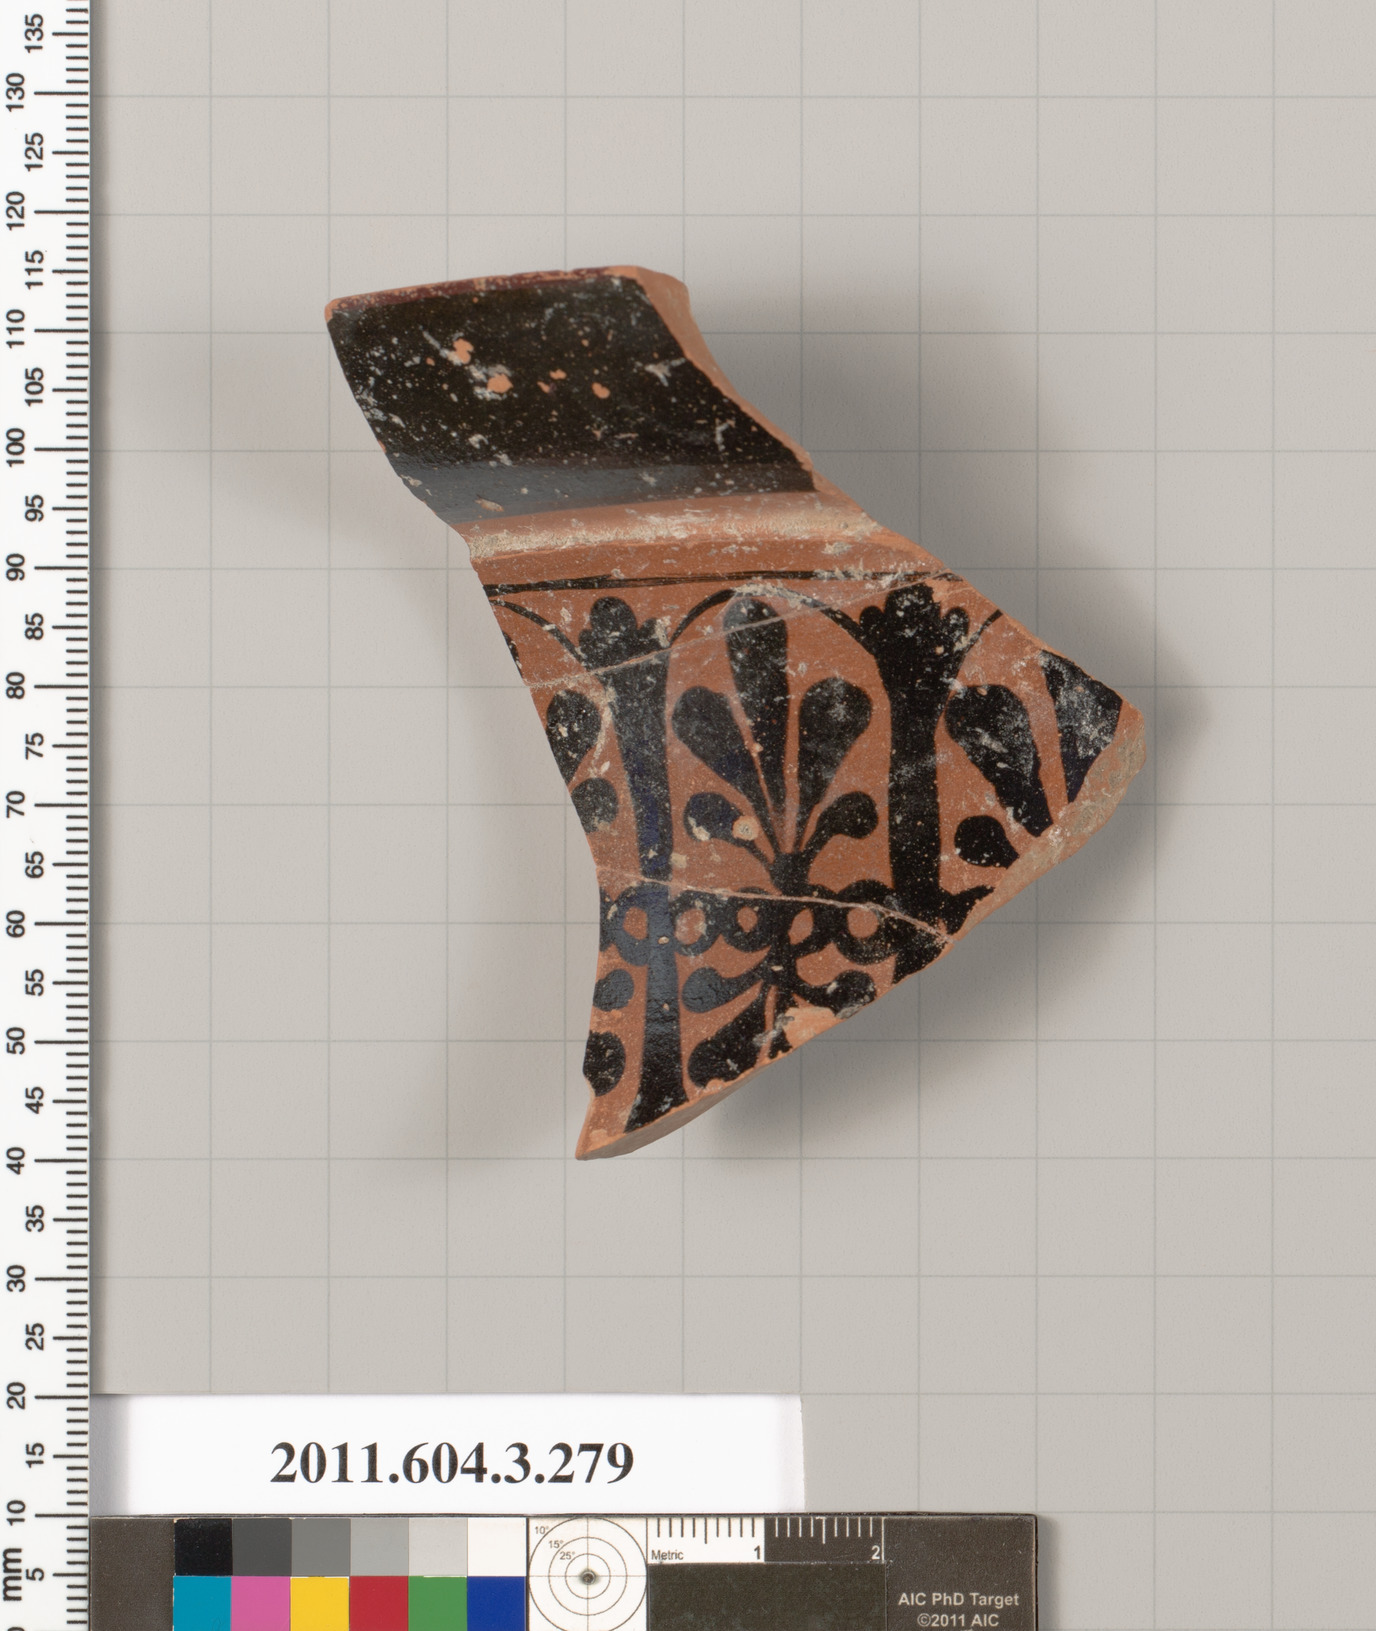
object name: neck amphora fragment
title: Terracotta fragment of a neck-amphora (jar)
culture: greek, attic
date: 520-510 BCE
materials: terracotta